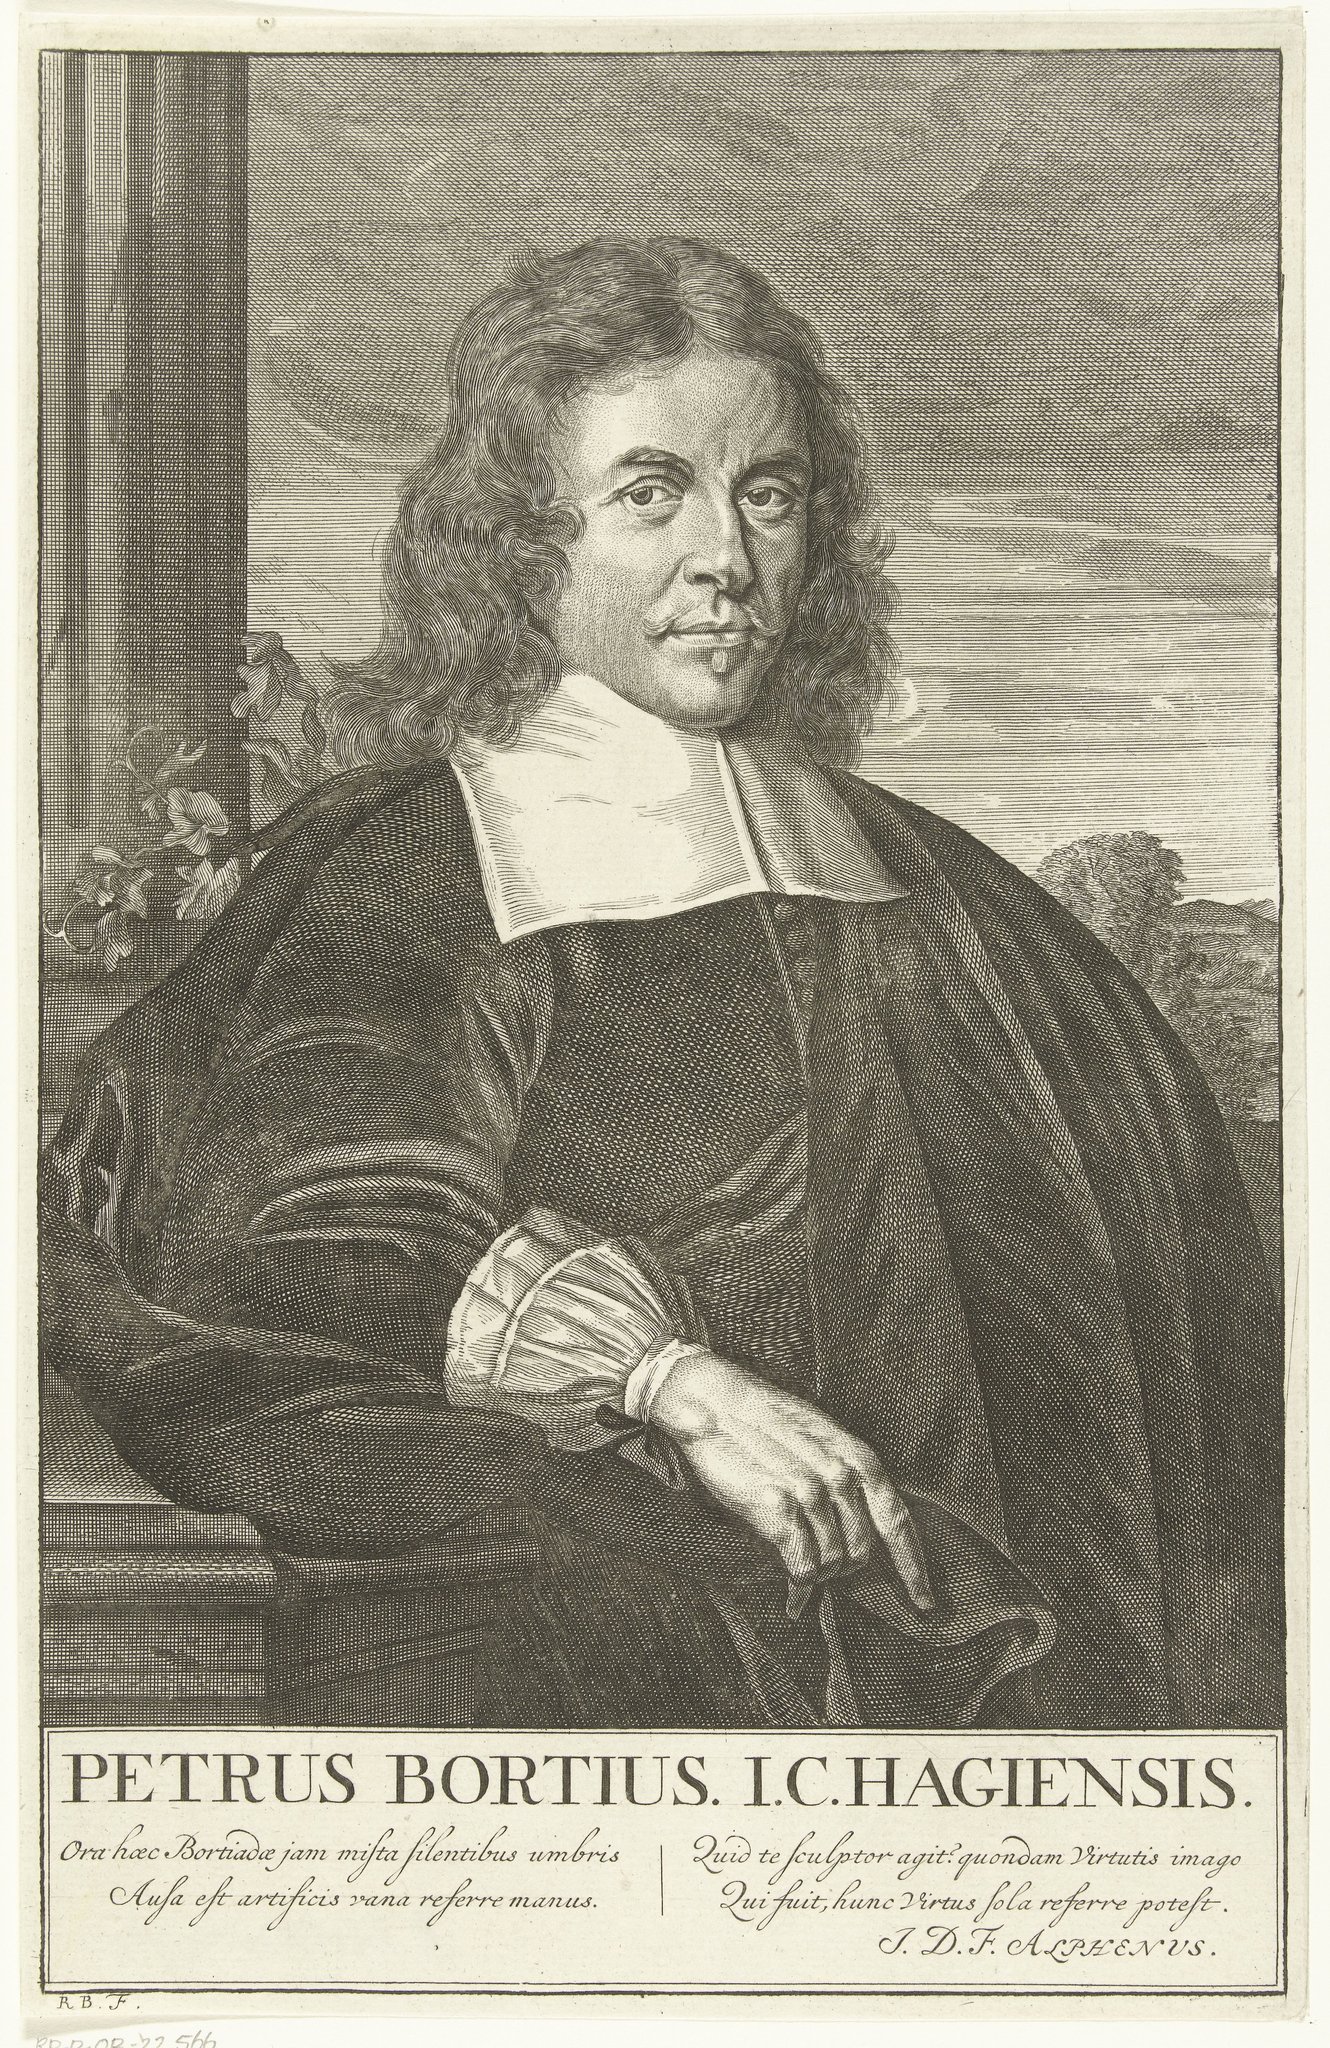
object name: print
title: Portret van Petrus Bortius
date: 1673-1744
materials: paper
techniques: engraving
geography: netherlands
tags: historical persons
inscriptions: collector's mark: Lugt 2228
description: Vergelijk een prent van Hendrik Bary met een zeer vergelijkbaar portret, waarschijnlijk maakten de kunstenaars gebruik van dezelfde bron (zie Hollstein, nr. 34).